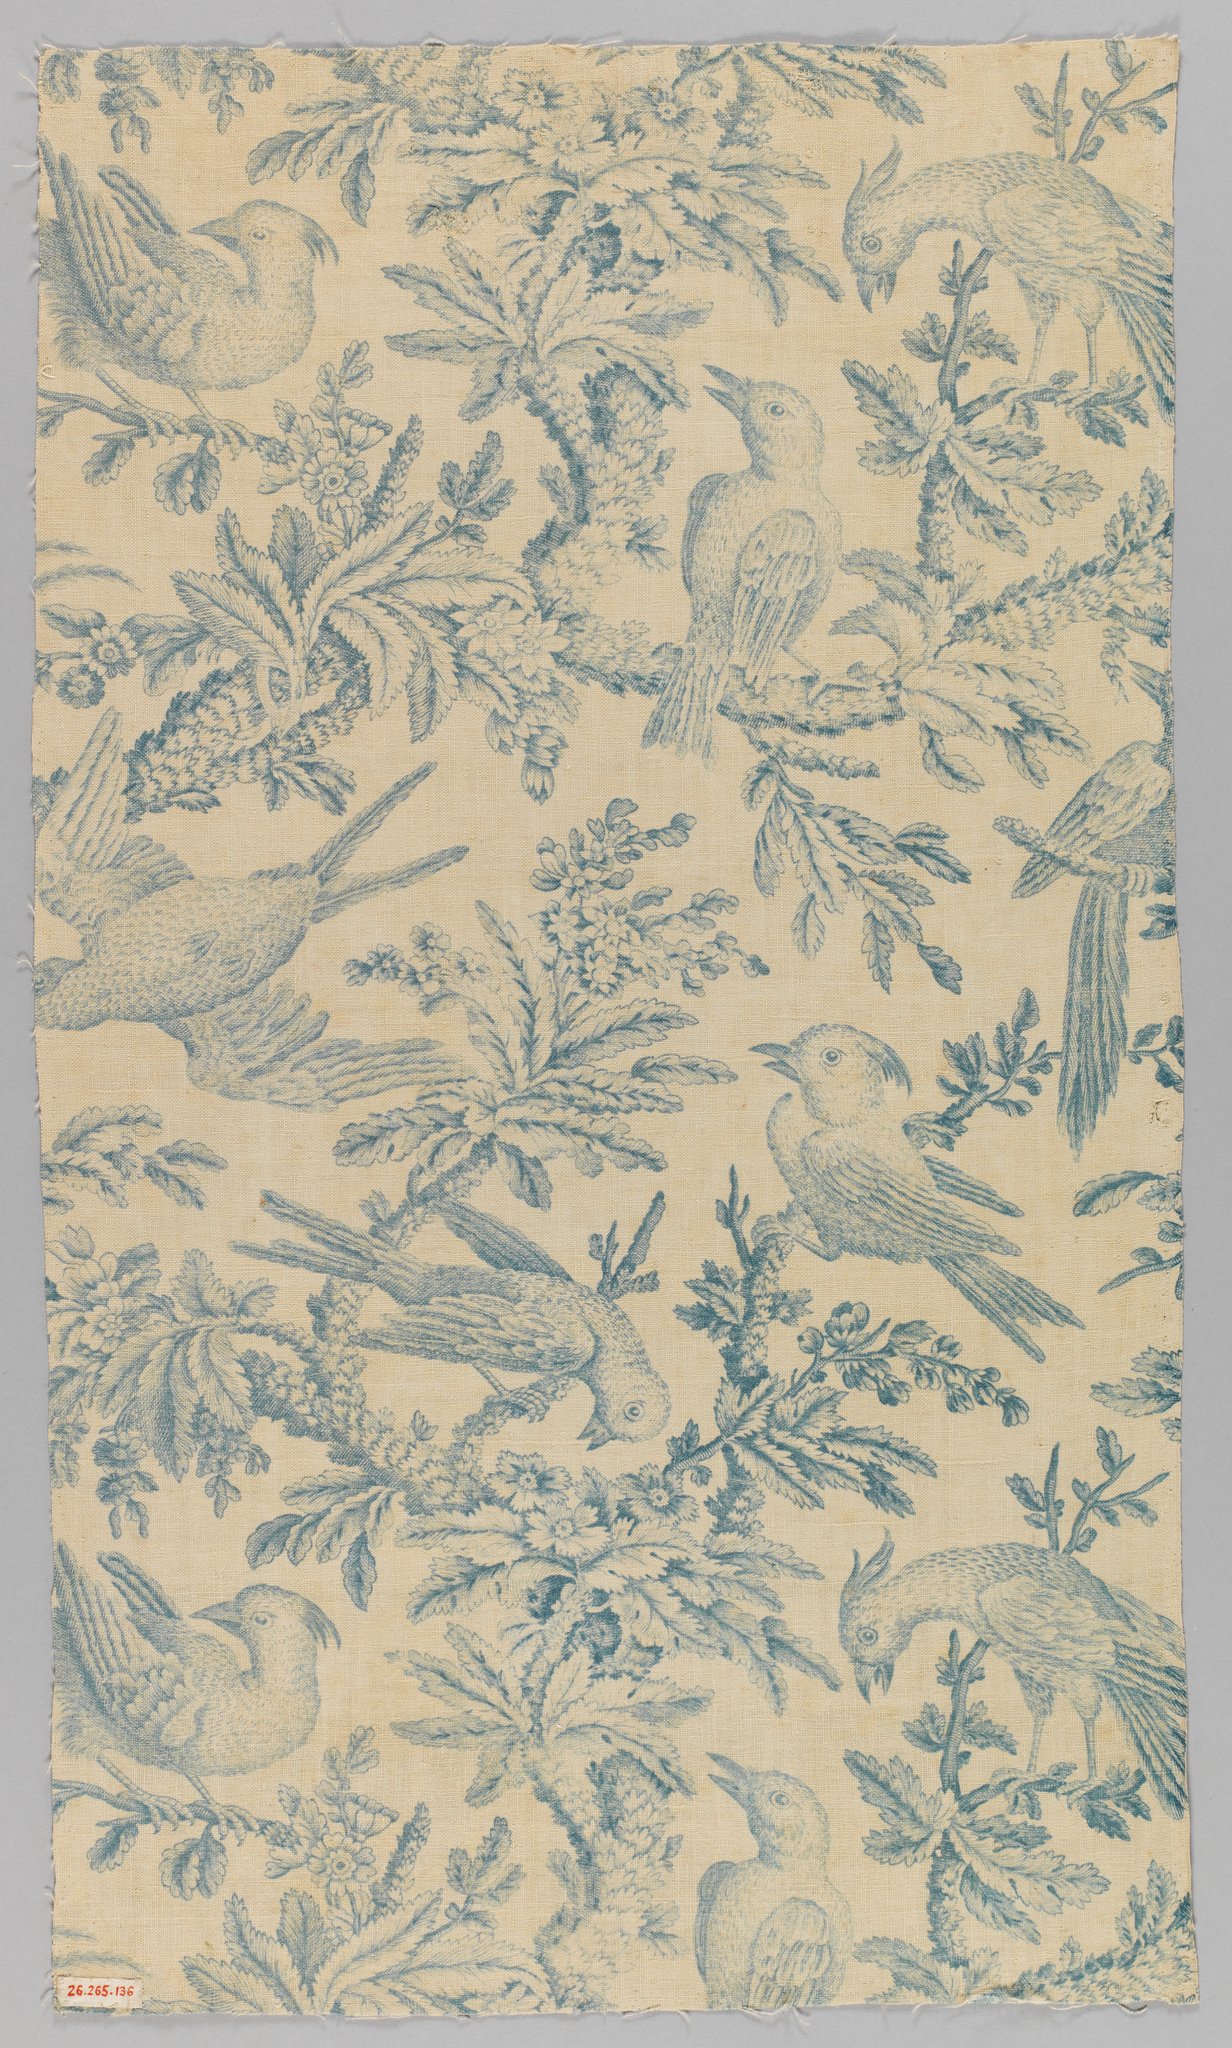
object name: furnishing textile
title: Pictorial print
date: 1701-1800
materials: linen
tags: birds